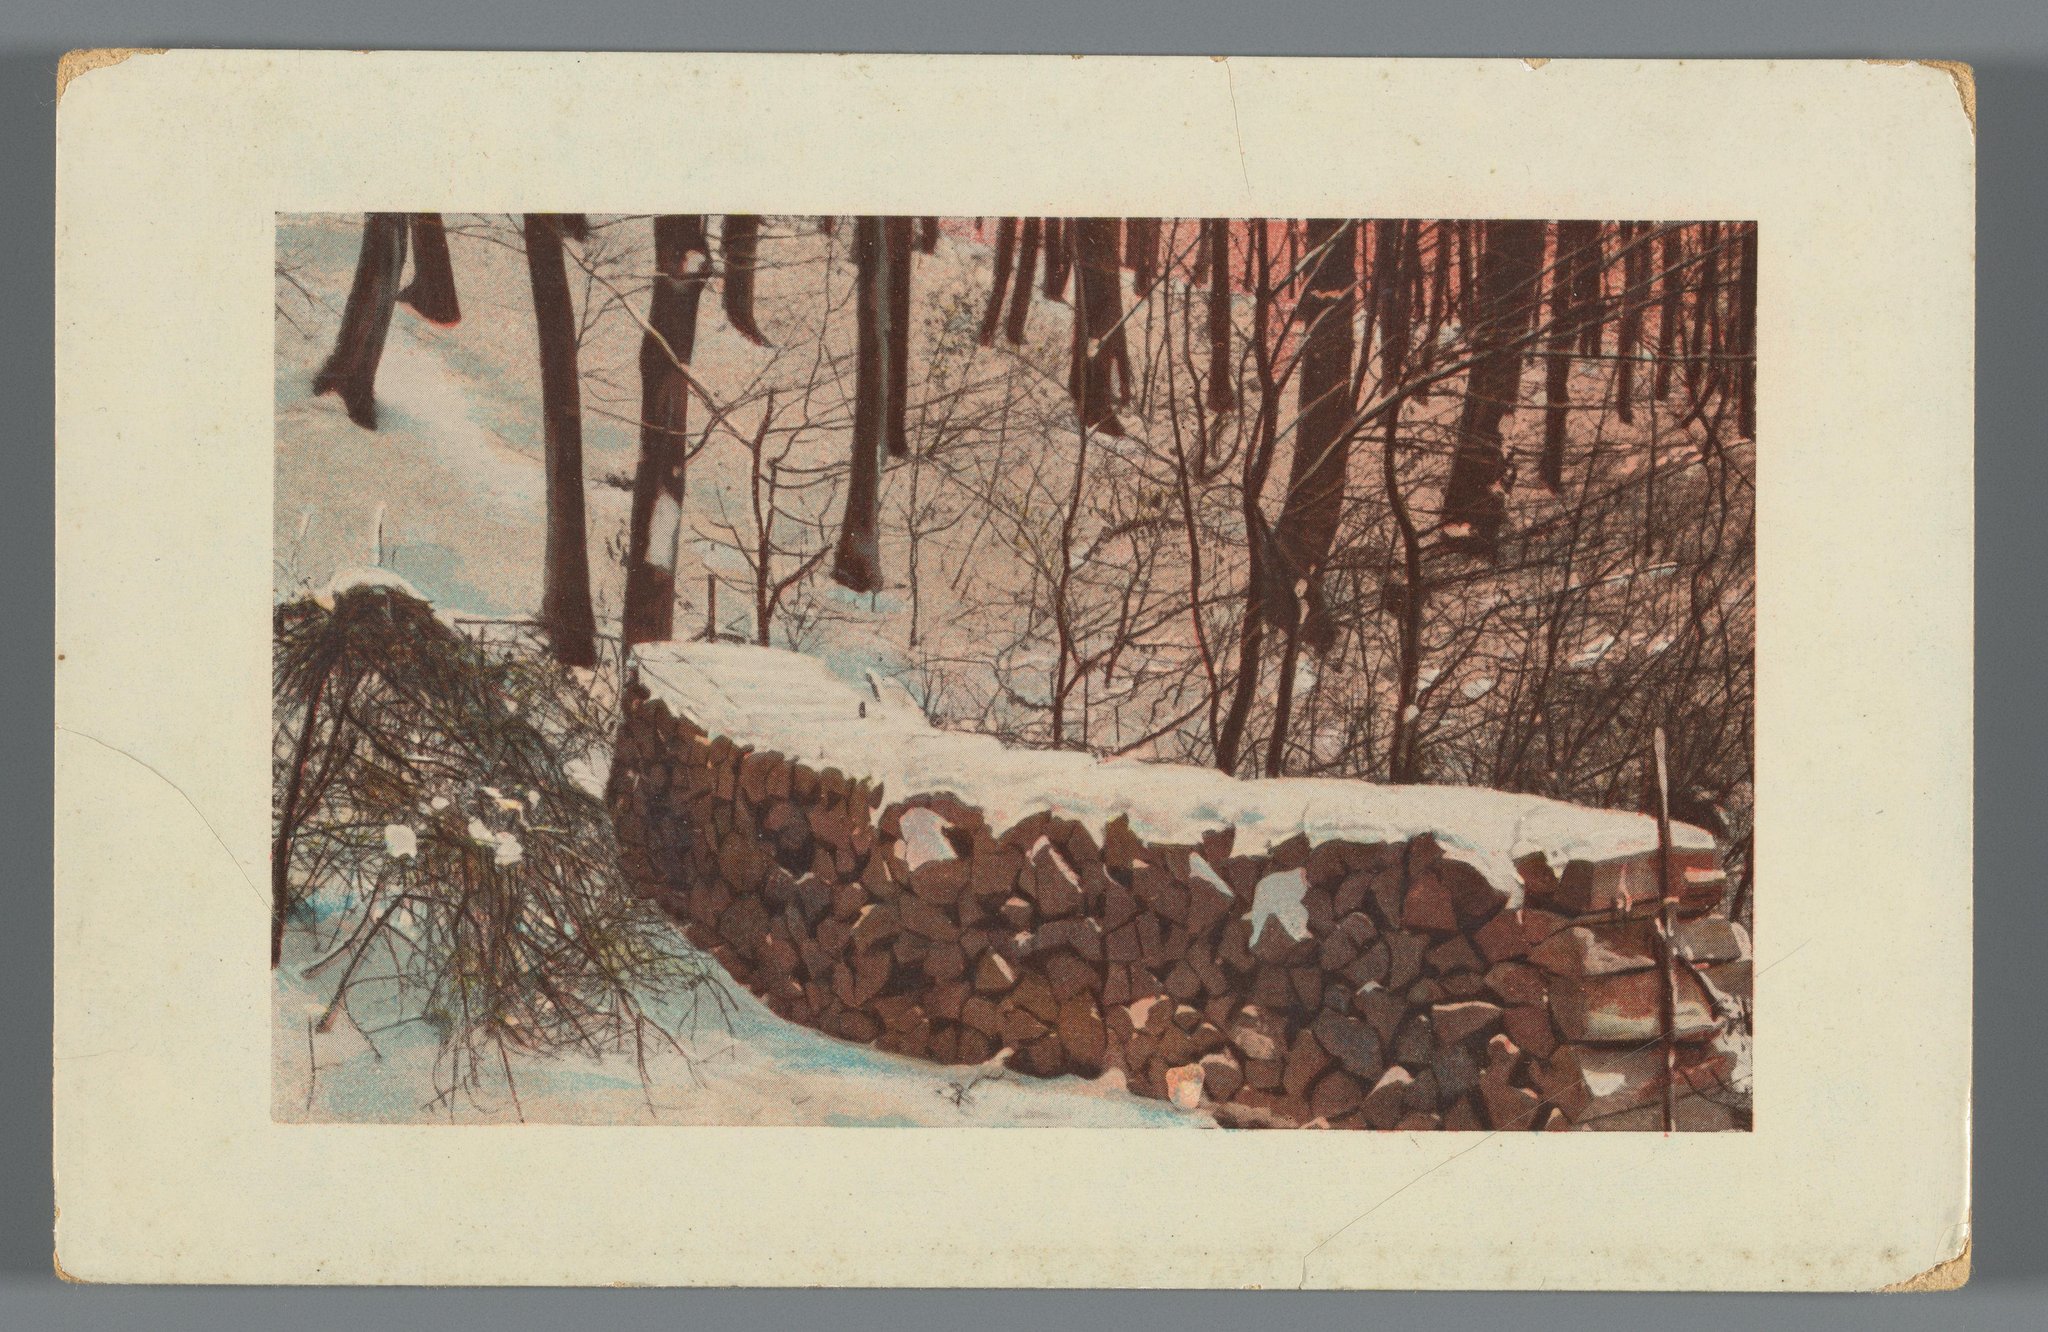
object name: photomechanical print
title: Sneeuwlandschap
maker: Anonymous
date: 1881-1960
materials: ink, paper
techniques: lithograph, writing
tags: forest, wood, snow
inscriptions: number: ‘Serie 1033.’, inscription: ‘met vriendelijke groet/ Mr Herenberg’